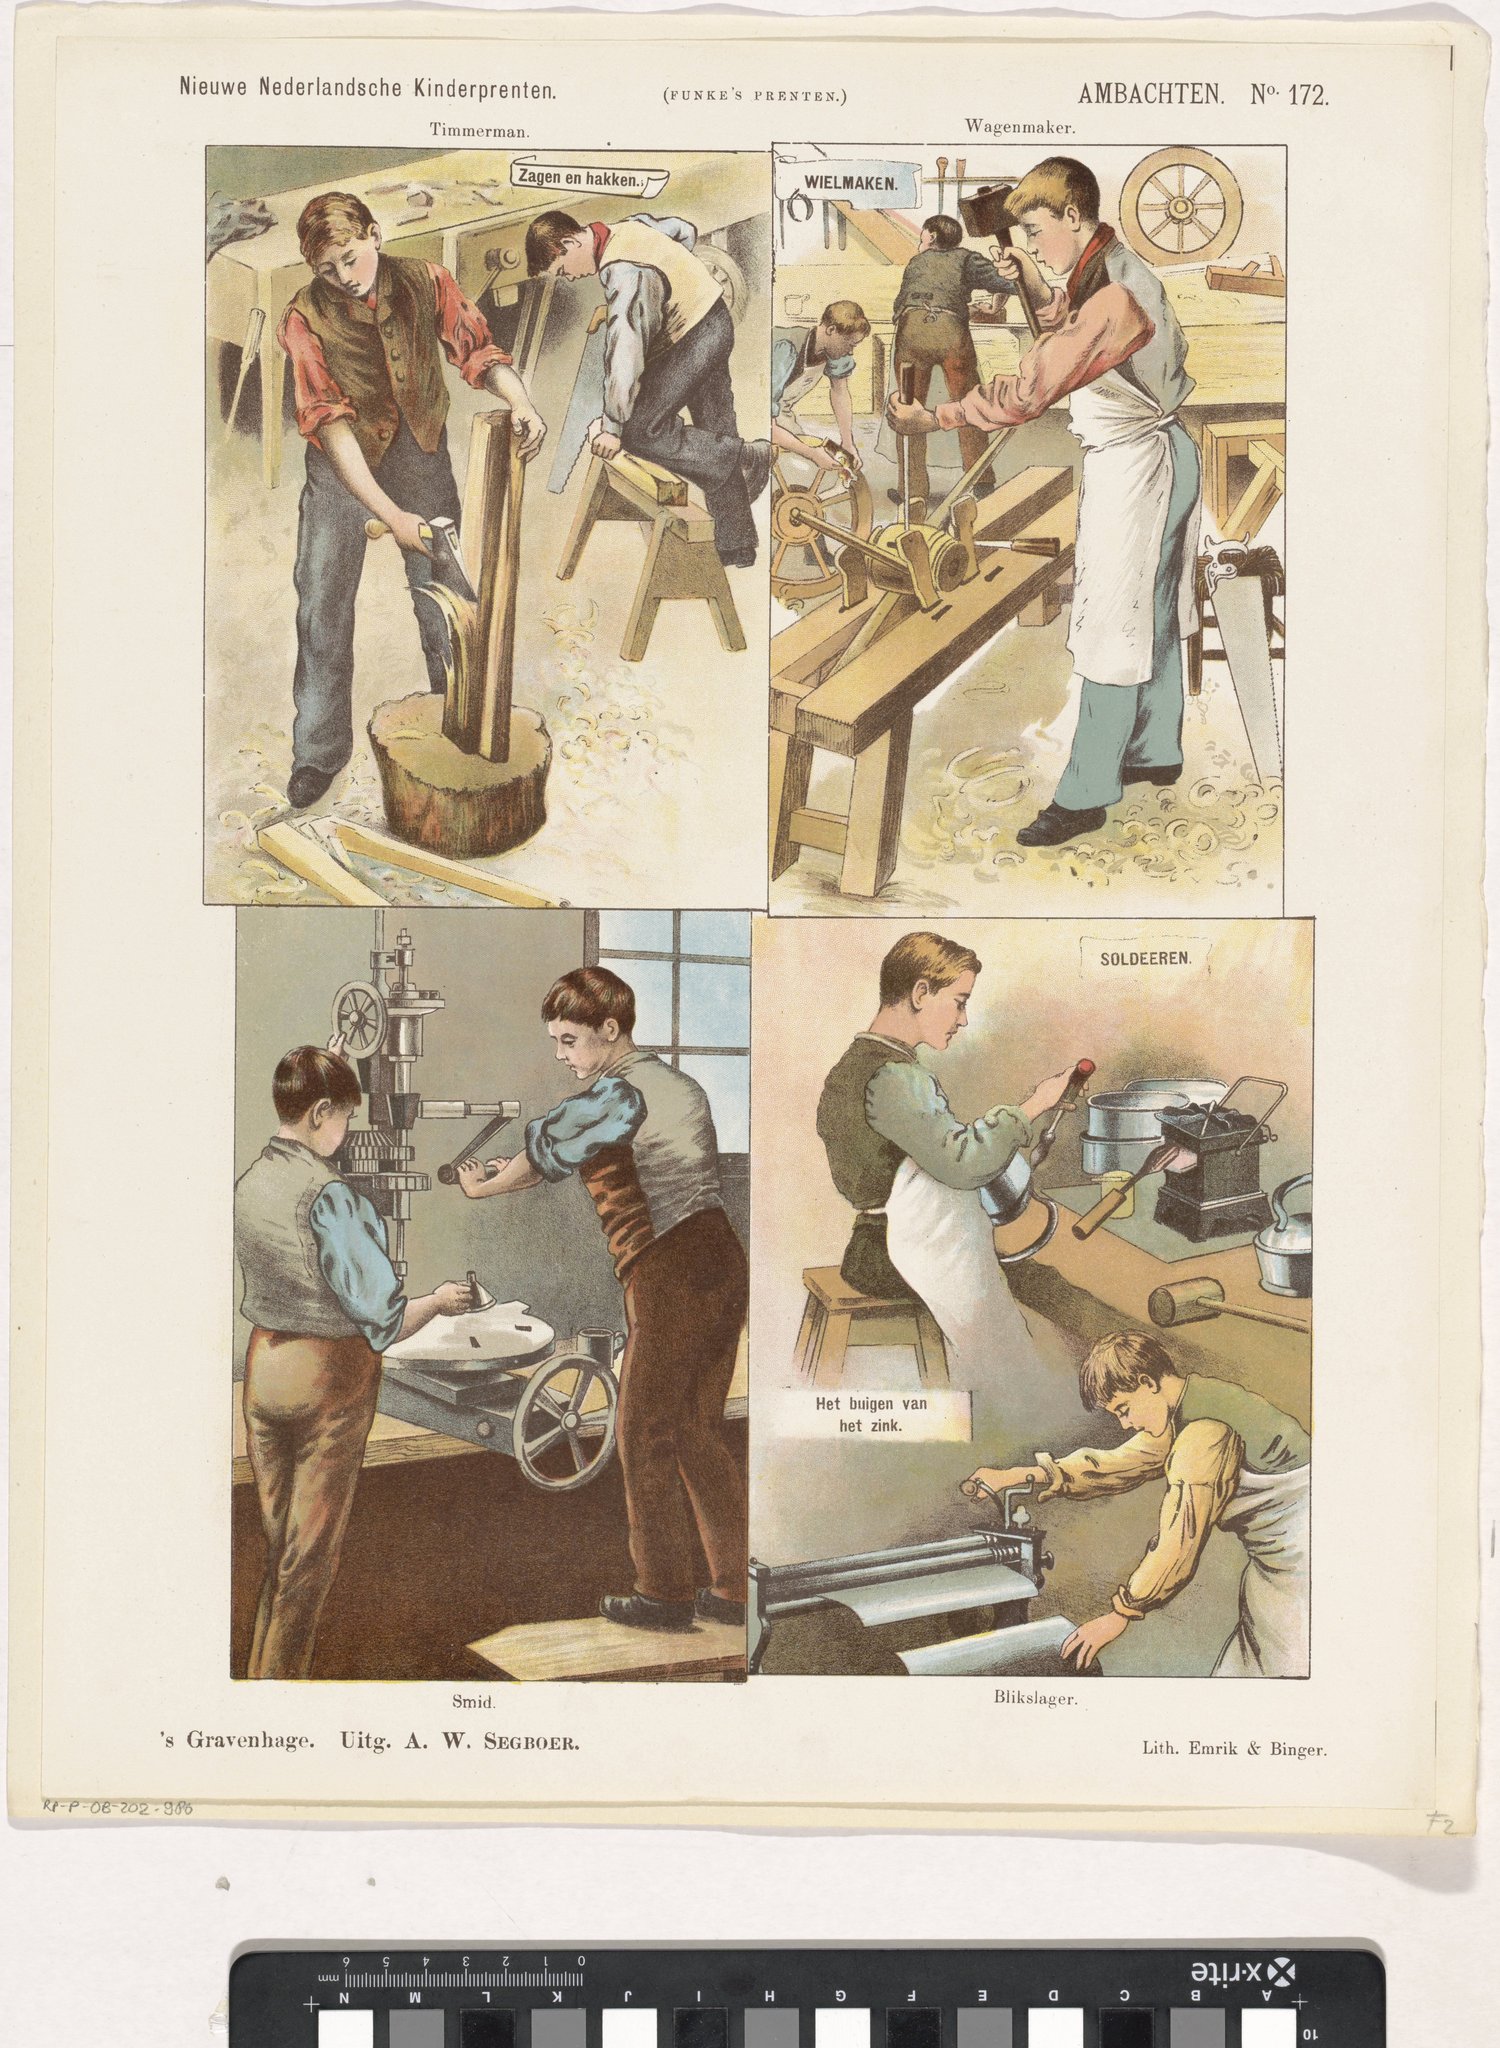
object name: print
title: Funke's prenten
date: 1903-1919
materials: paper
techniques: lithograph, letterpress printing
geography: haarlem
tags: carpenter, craft-production, skilled handiwork, smith, blacksmith, crafts and industries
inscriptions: collector's mark: Lugt 2760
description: Blad met 4 voorstellingen van een timmerman, een wagenmaker, een smid en een blikslager. Genummerd rechtsboven: No. 172.